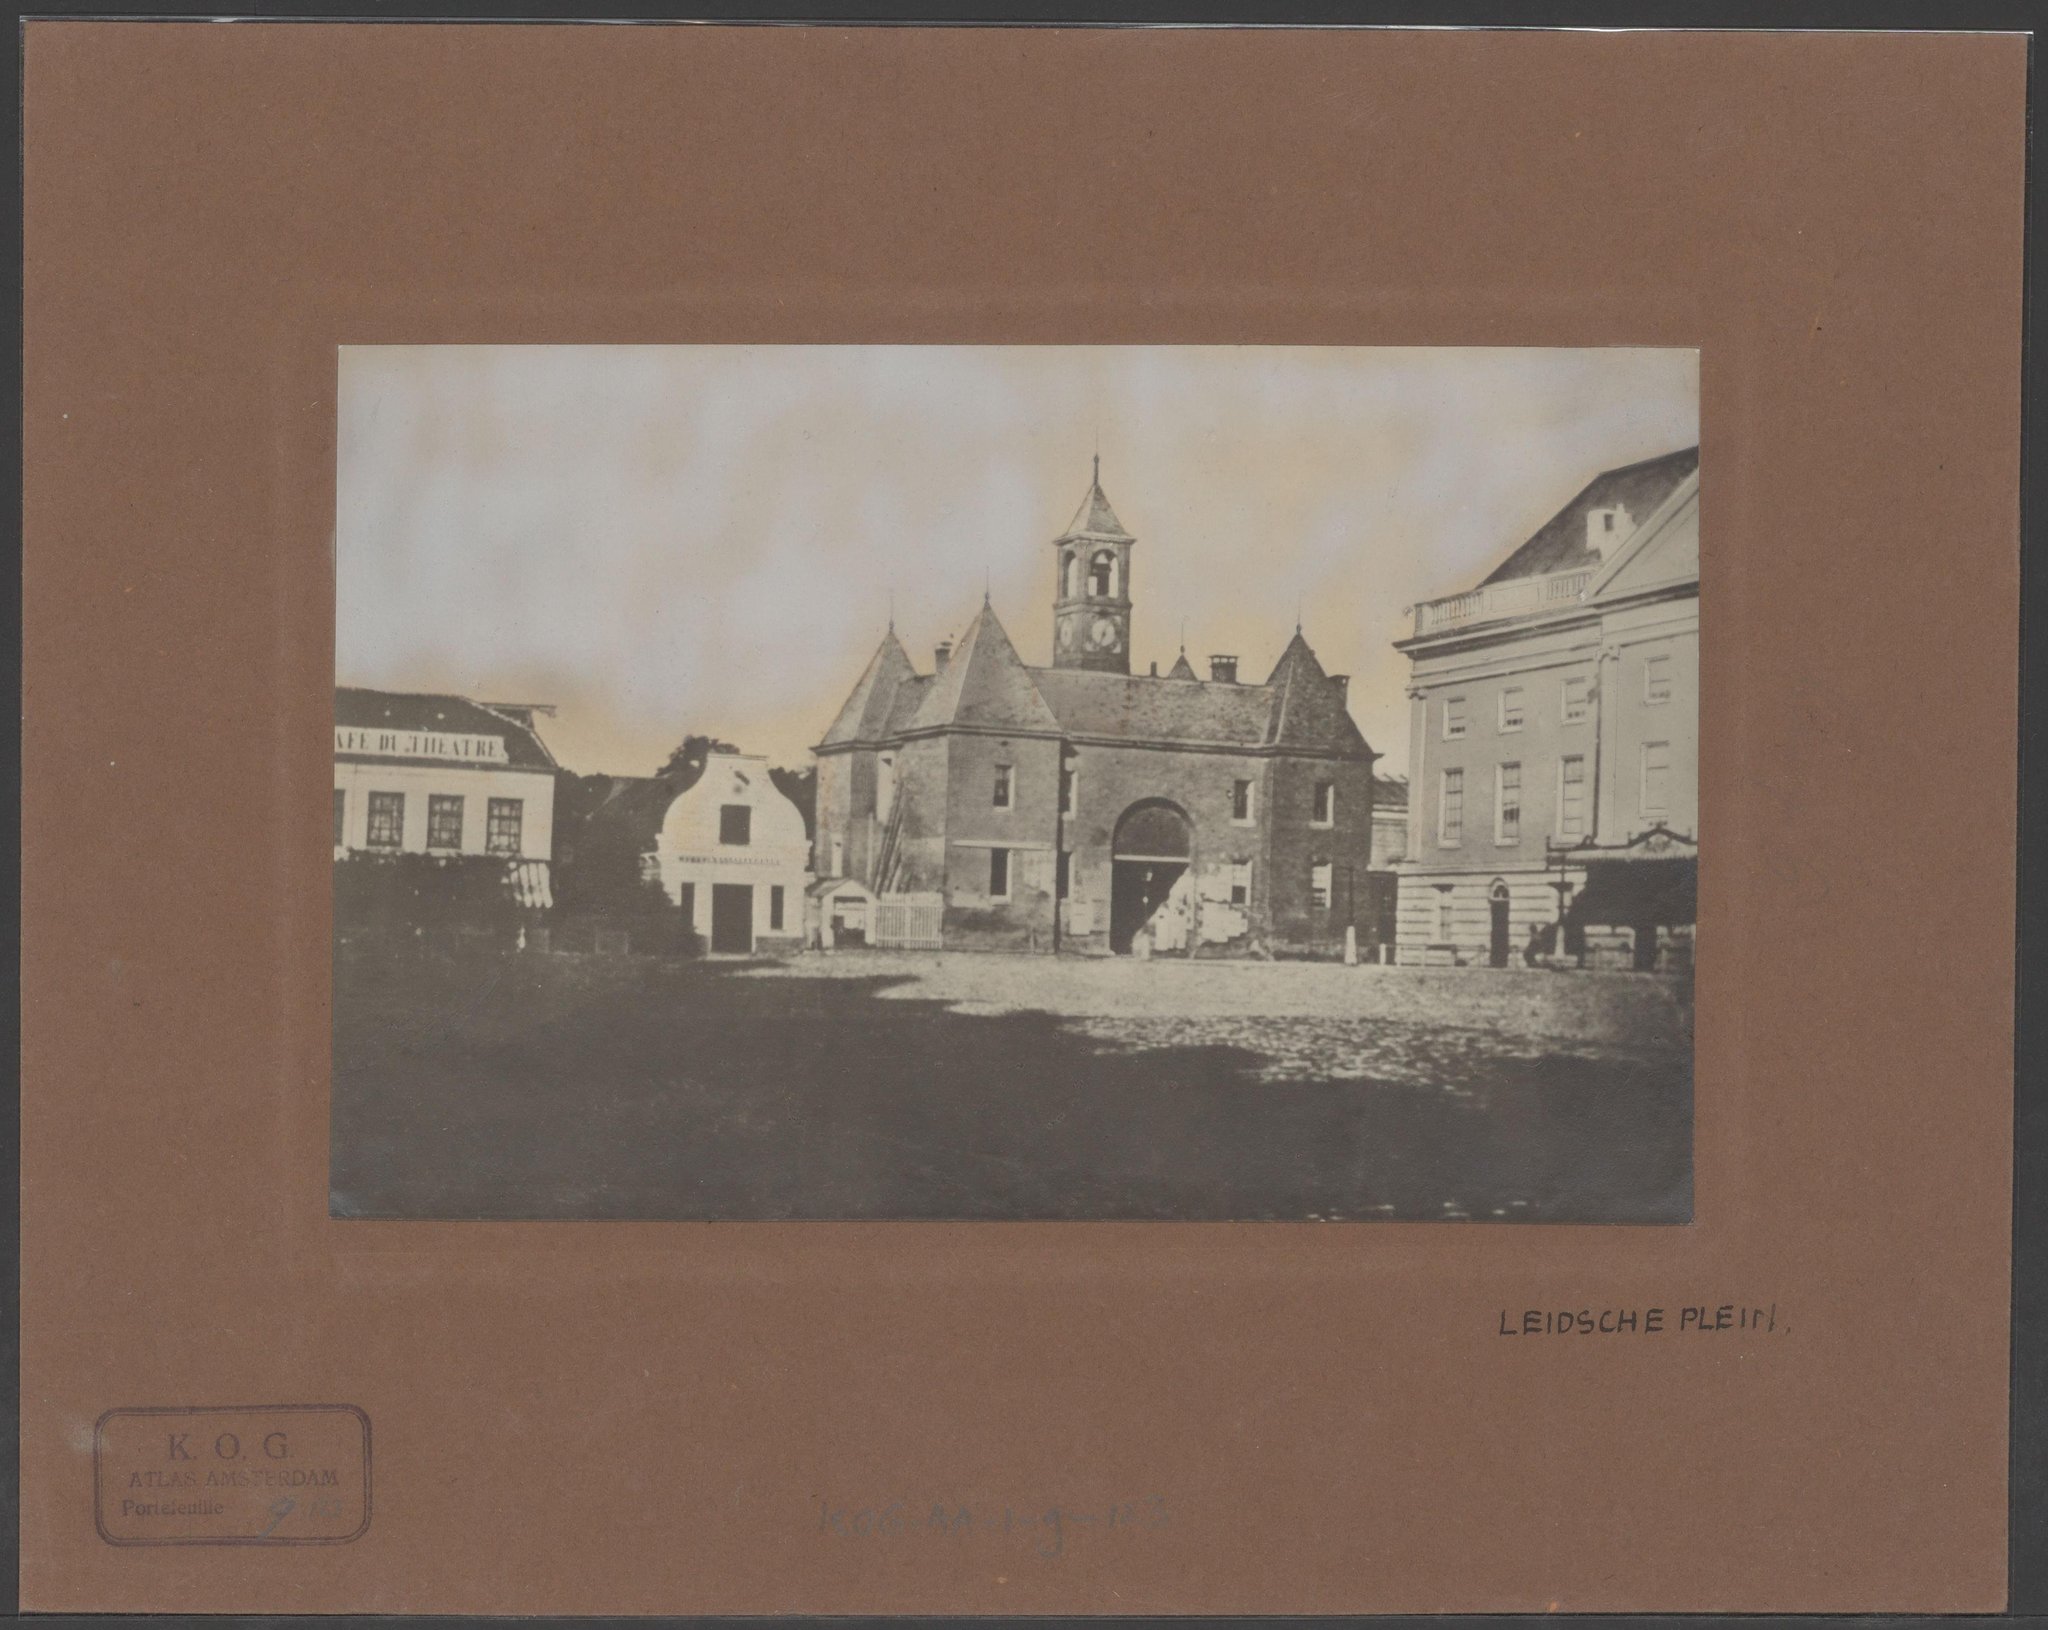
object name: photograph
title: Gezicht op de Leidsepoort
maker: Anonymous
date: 1860-1950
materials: paper, cardboard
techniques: gelatin silver print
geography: amsterdam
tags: square, place, circus, etc., city-view in general; 'veduta', city-gate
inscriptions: collector's mark: ‘9.123’ Lugt 1641b, inscription: ‘Geschenk v/d heer- / Wijsman-’, inscription: ‘Leidsche Plein’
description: Onderwerpsrubriek binnen de Atlas Amsterdam: 2e Laurierdwarsstraat (Vuile Weespad), Leidschegracht, Leidschekade, Leidscheplein, Leidschestraat, v. Lennepkade, Lijnbaansgracht, Lauriergracht, Leliedwarsstraat, Leliegracht, Lindengracht, Lombardsteeg, Looiersgracht, Looiersstraat (Nieuwe), Leidekkerssteeg.